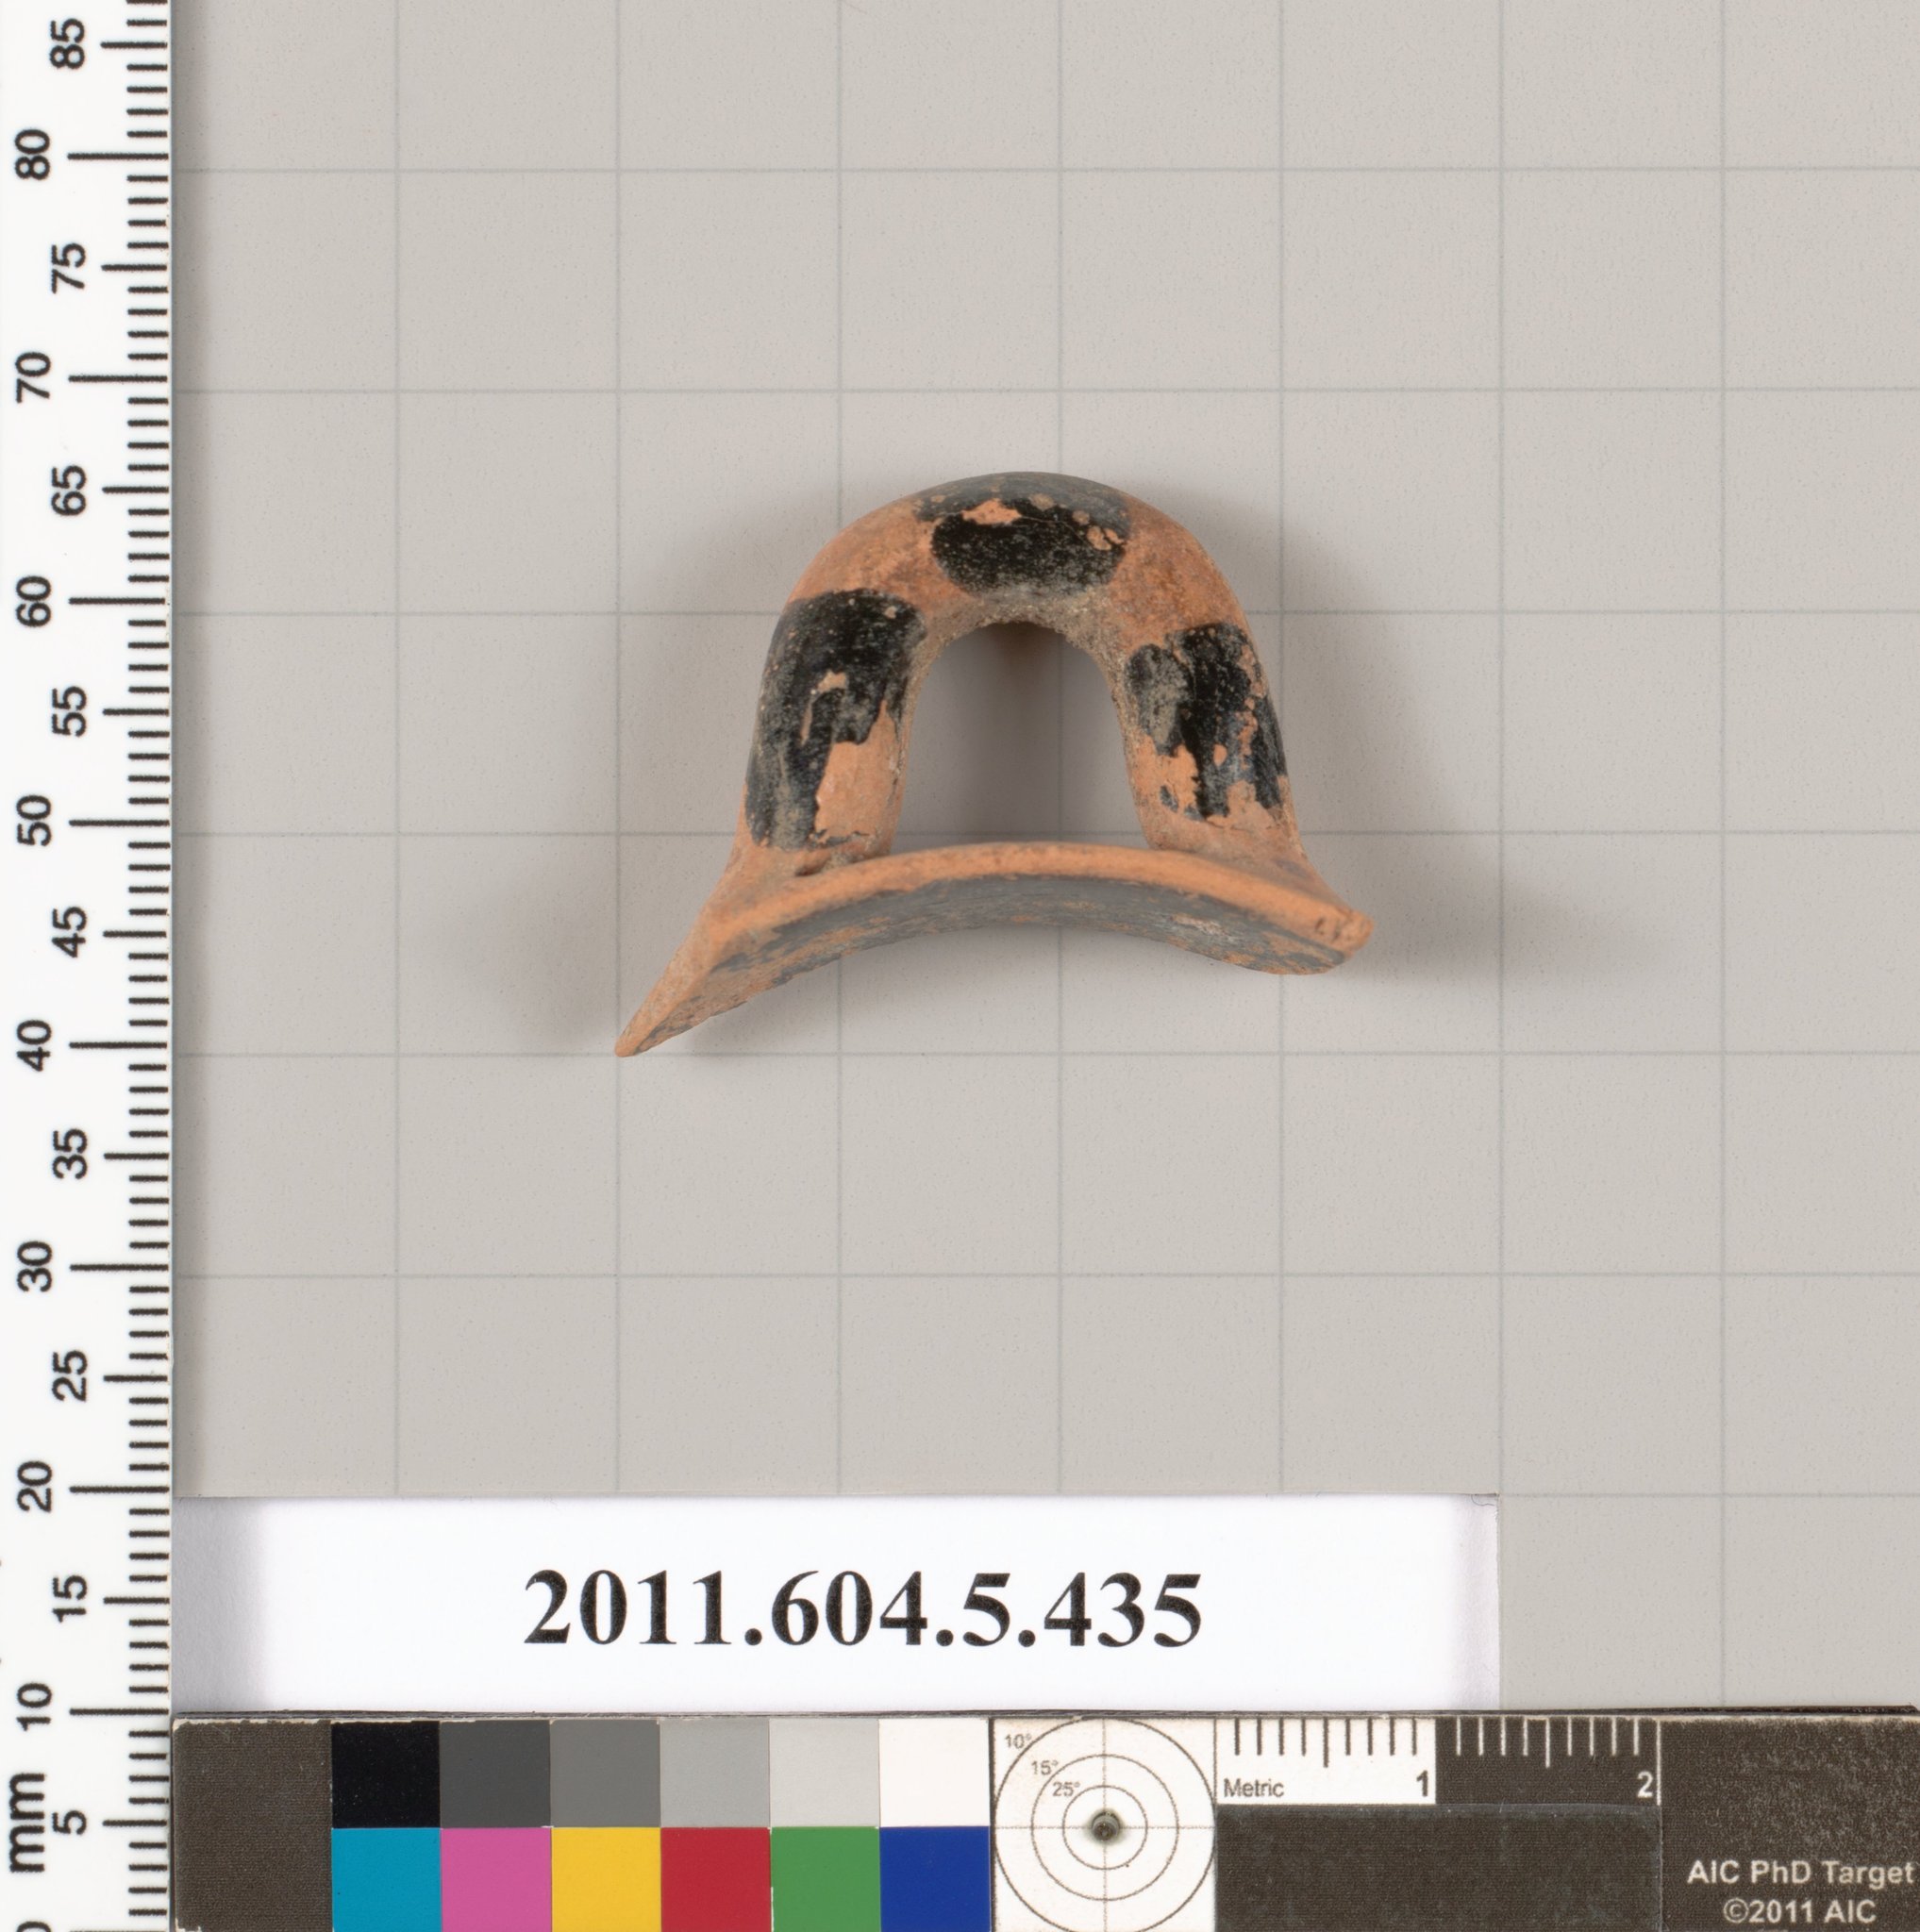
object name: kylix fragment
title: Terracotta rim fragment of a kylix (drinking cup)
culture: greek, attic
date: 600-401 BCE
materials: terracotta